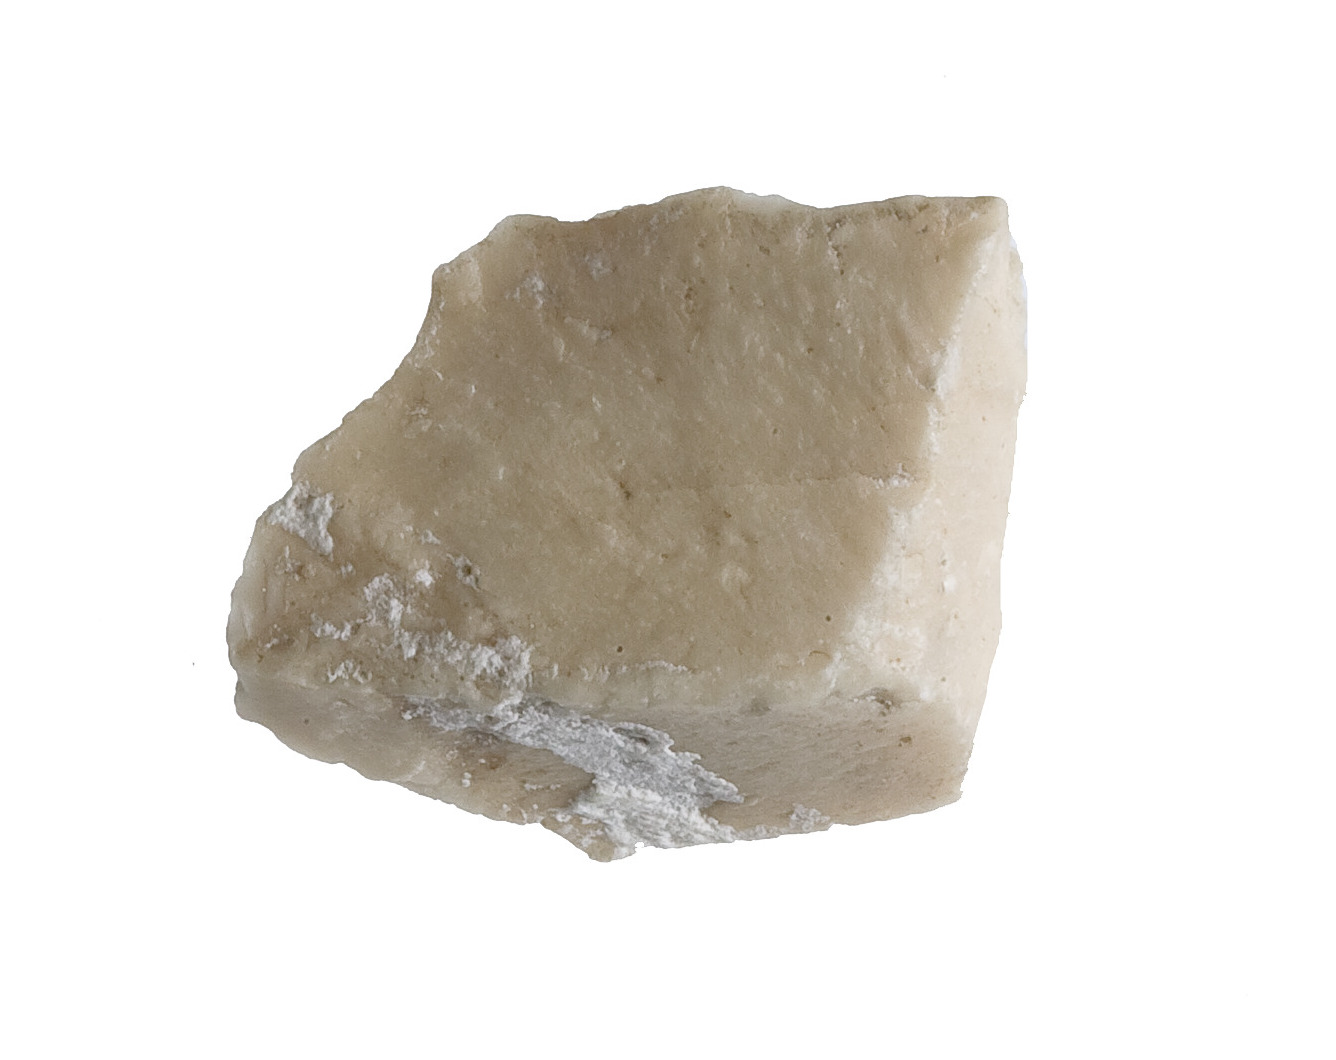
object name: chip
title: Flake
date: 1353-1336 BCE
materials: limestone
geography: egypt